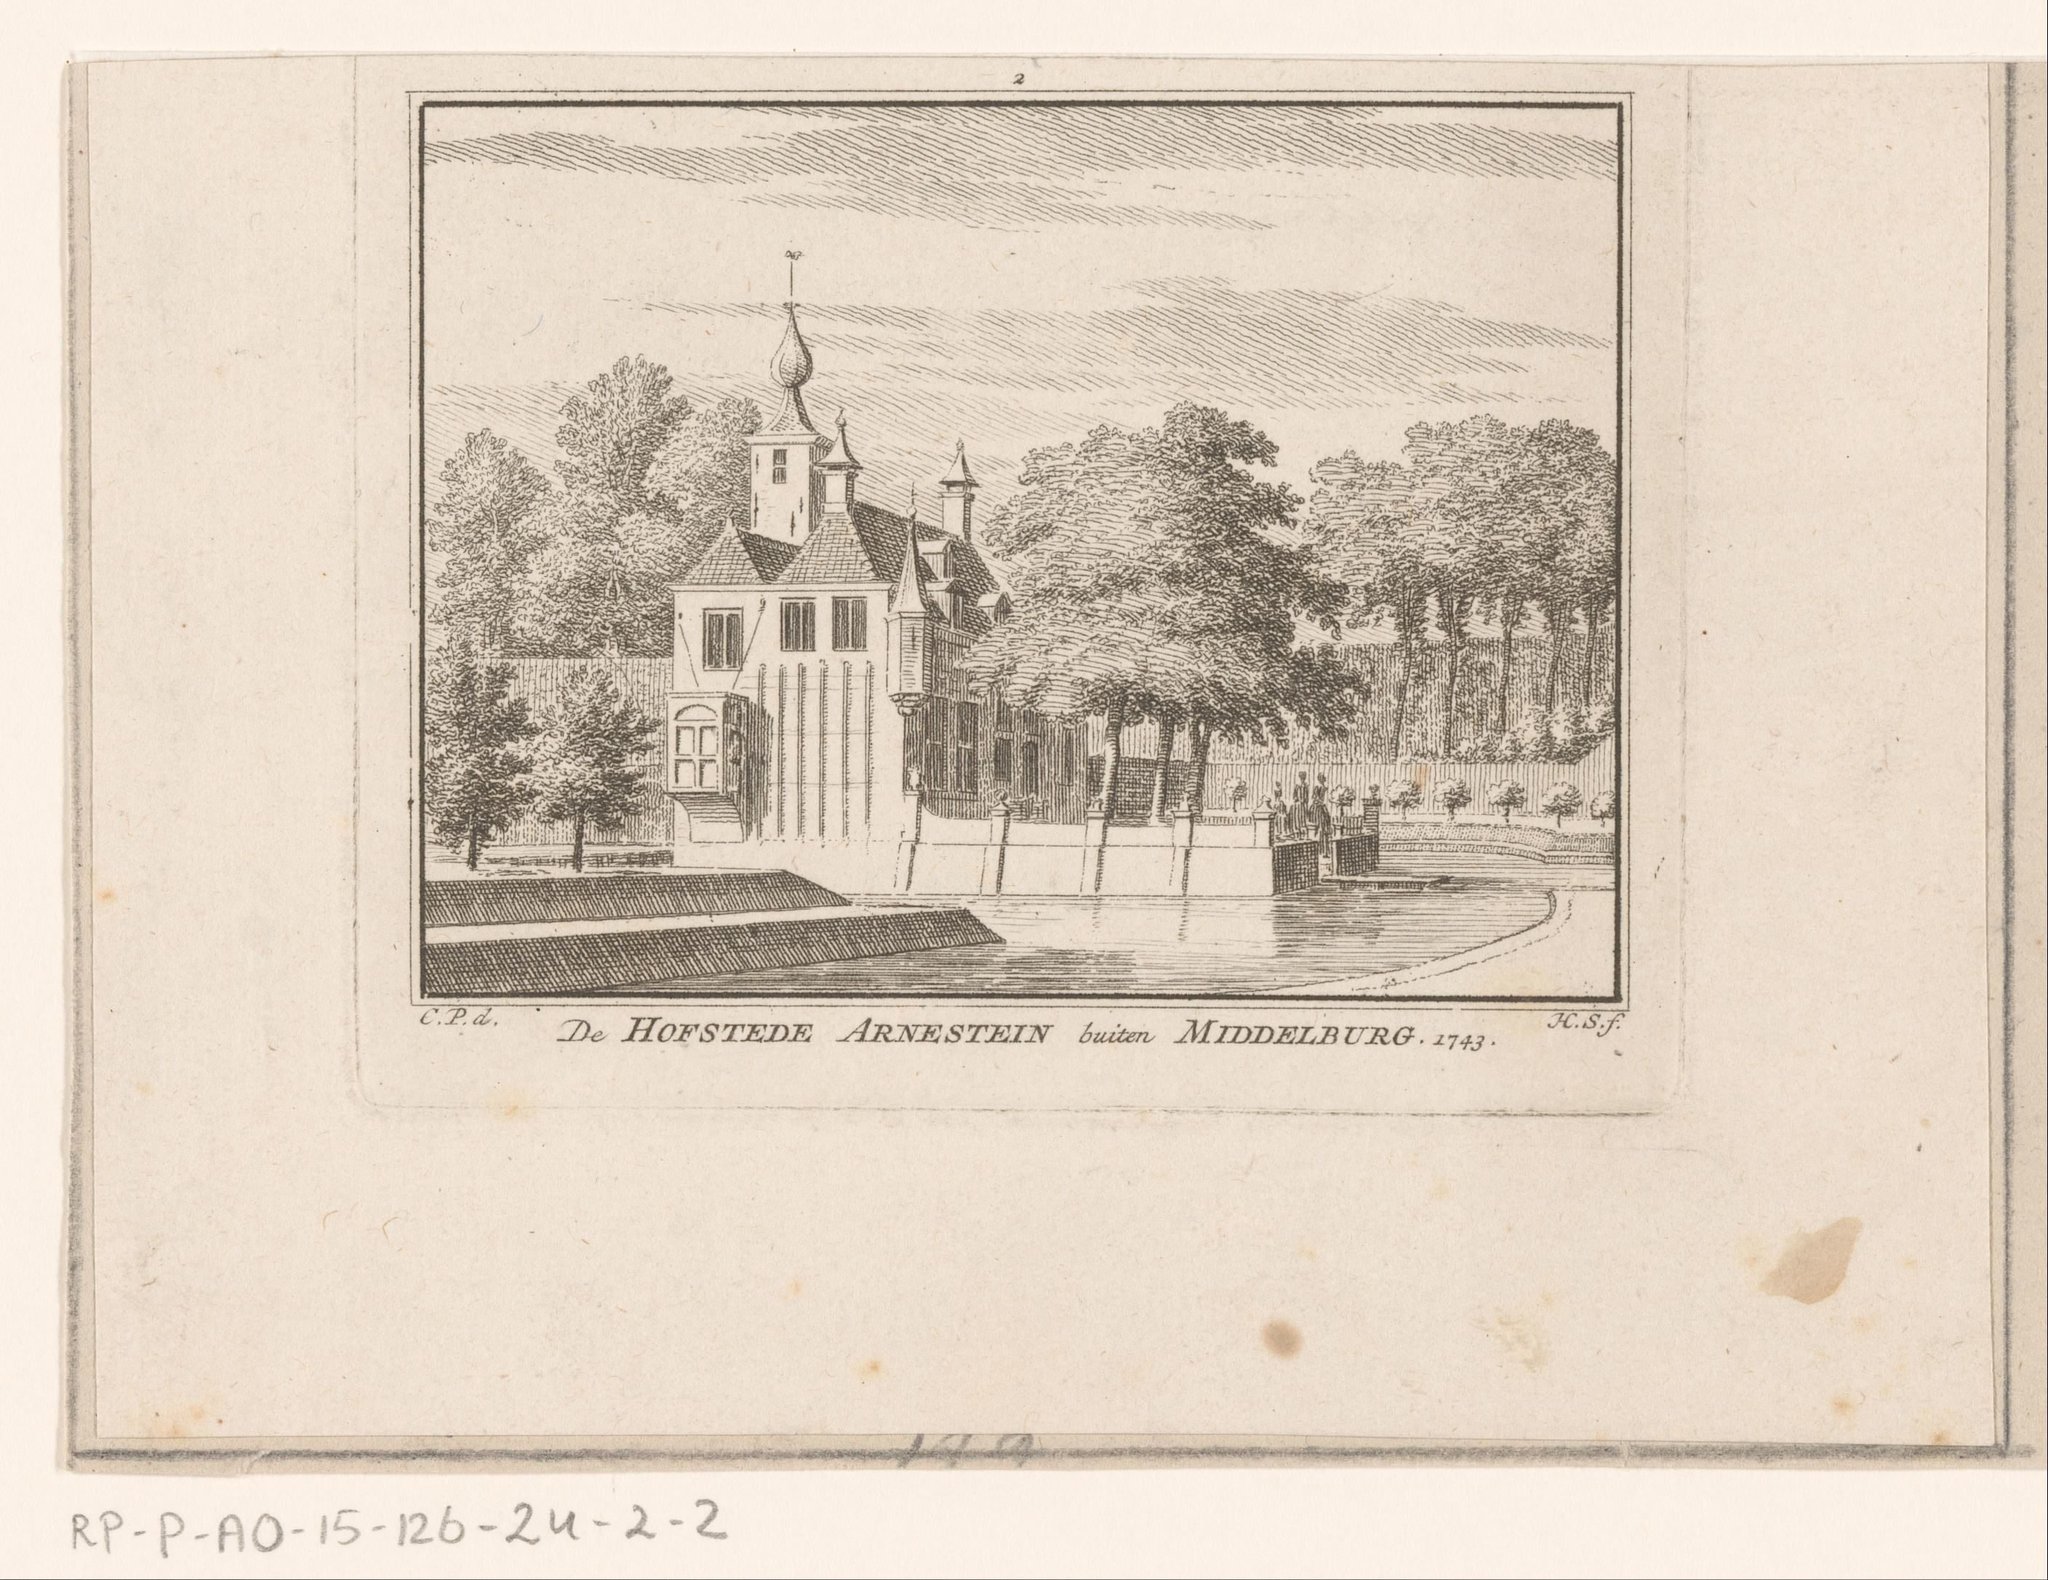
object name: print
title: De Hofstede Arnestein buiten Middelburg. 1743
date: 1754-1792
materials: paper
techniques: etching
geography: haarlem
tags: country-house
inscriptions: collector's mark: Lugt 2228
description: Prent ook gebruikt in: Het verheerlykt Nederland of kabinet van hedendaagsche gezigten van steden, dorpen (…). 9 delen. Amsterdam: Isaak Tirion en weduwe Isaak Tirion, 1745-1774, dl. 5 (1754), ill. 2. Of in: Nederlandsche tafereelen; of eene keurige verzameling van negen honderd fraaije gezigten van steden, dorpen, sloten, oudheden [….]. 9 delen. Amsterdam: Jan de Groot, 1792, dl. 5, ill. 2.